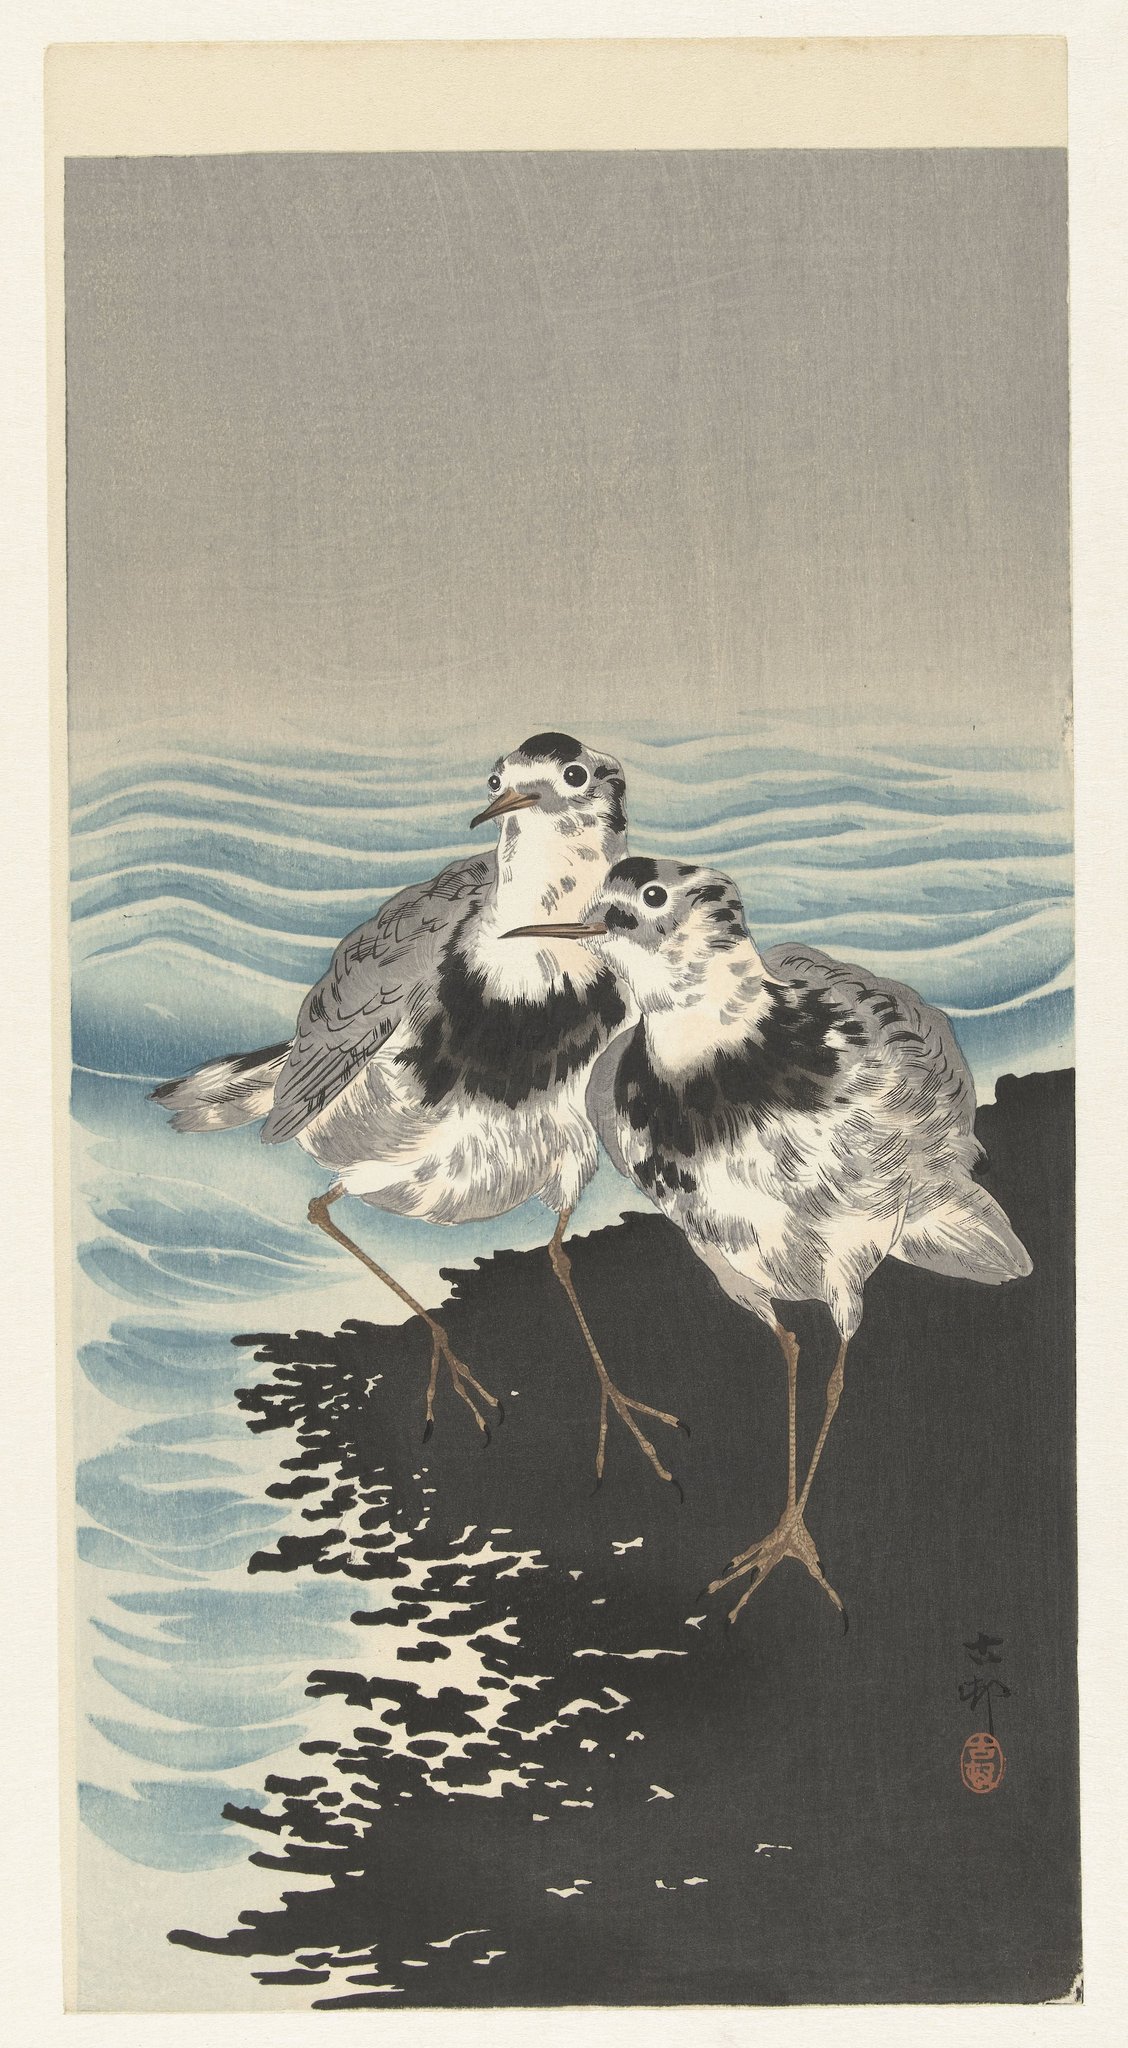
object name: print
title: Grote kanoetstrandlopers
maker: ohara koson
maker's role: print maker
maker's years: 1877-1945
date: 1900-1930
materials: paper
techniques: woodcut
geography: japan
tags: sea (seascape), shore-birds and wading-birds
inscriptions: collector's mark: Lugt 2228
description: Twee vogels, lopend op een zwarte kust, langs een woelige zee.